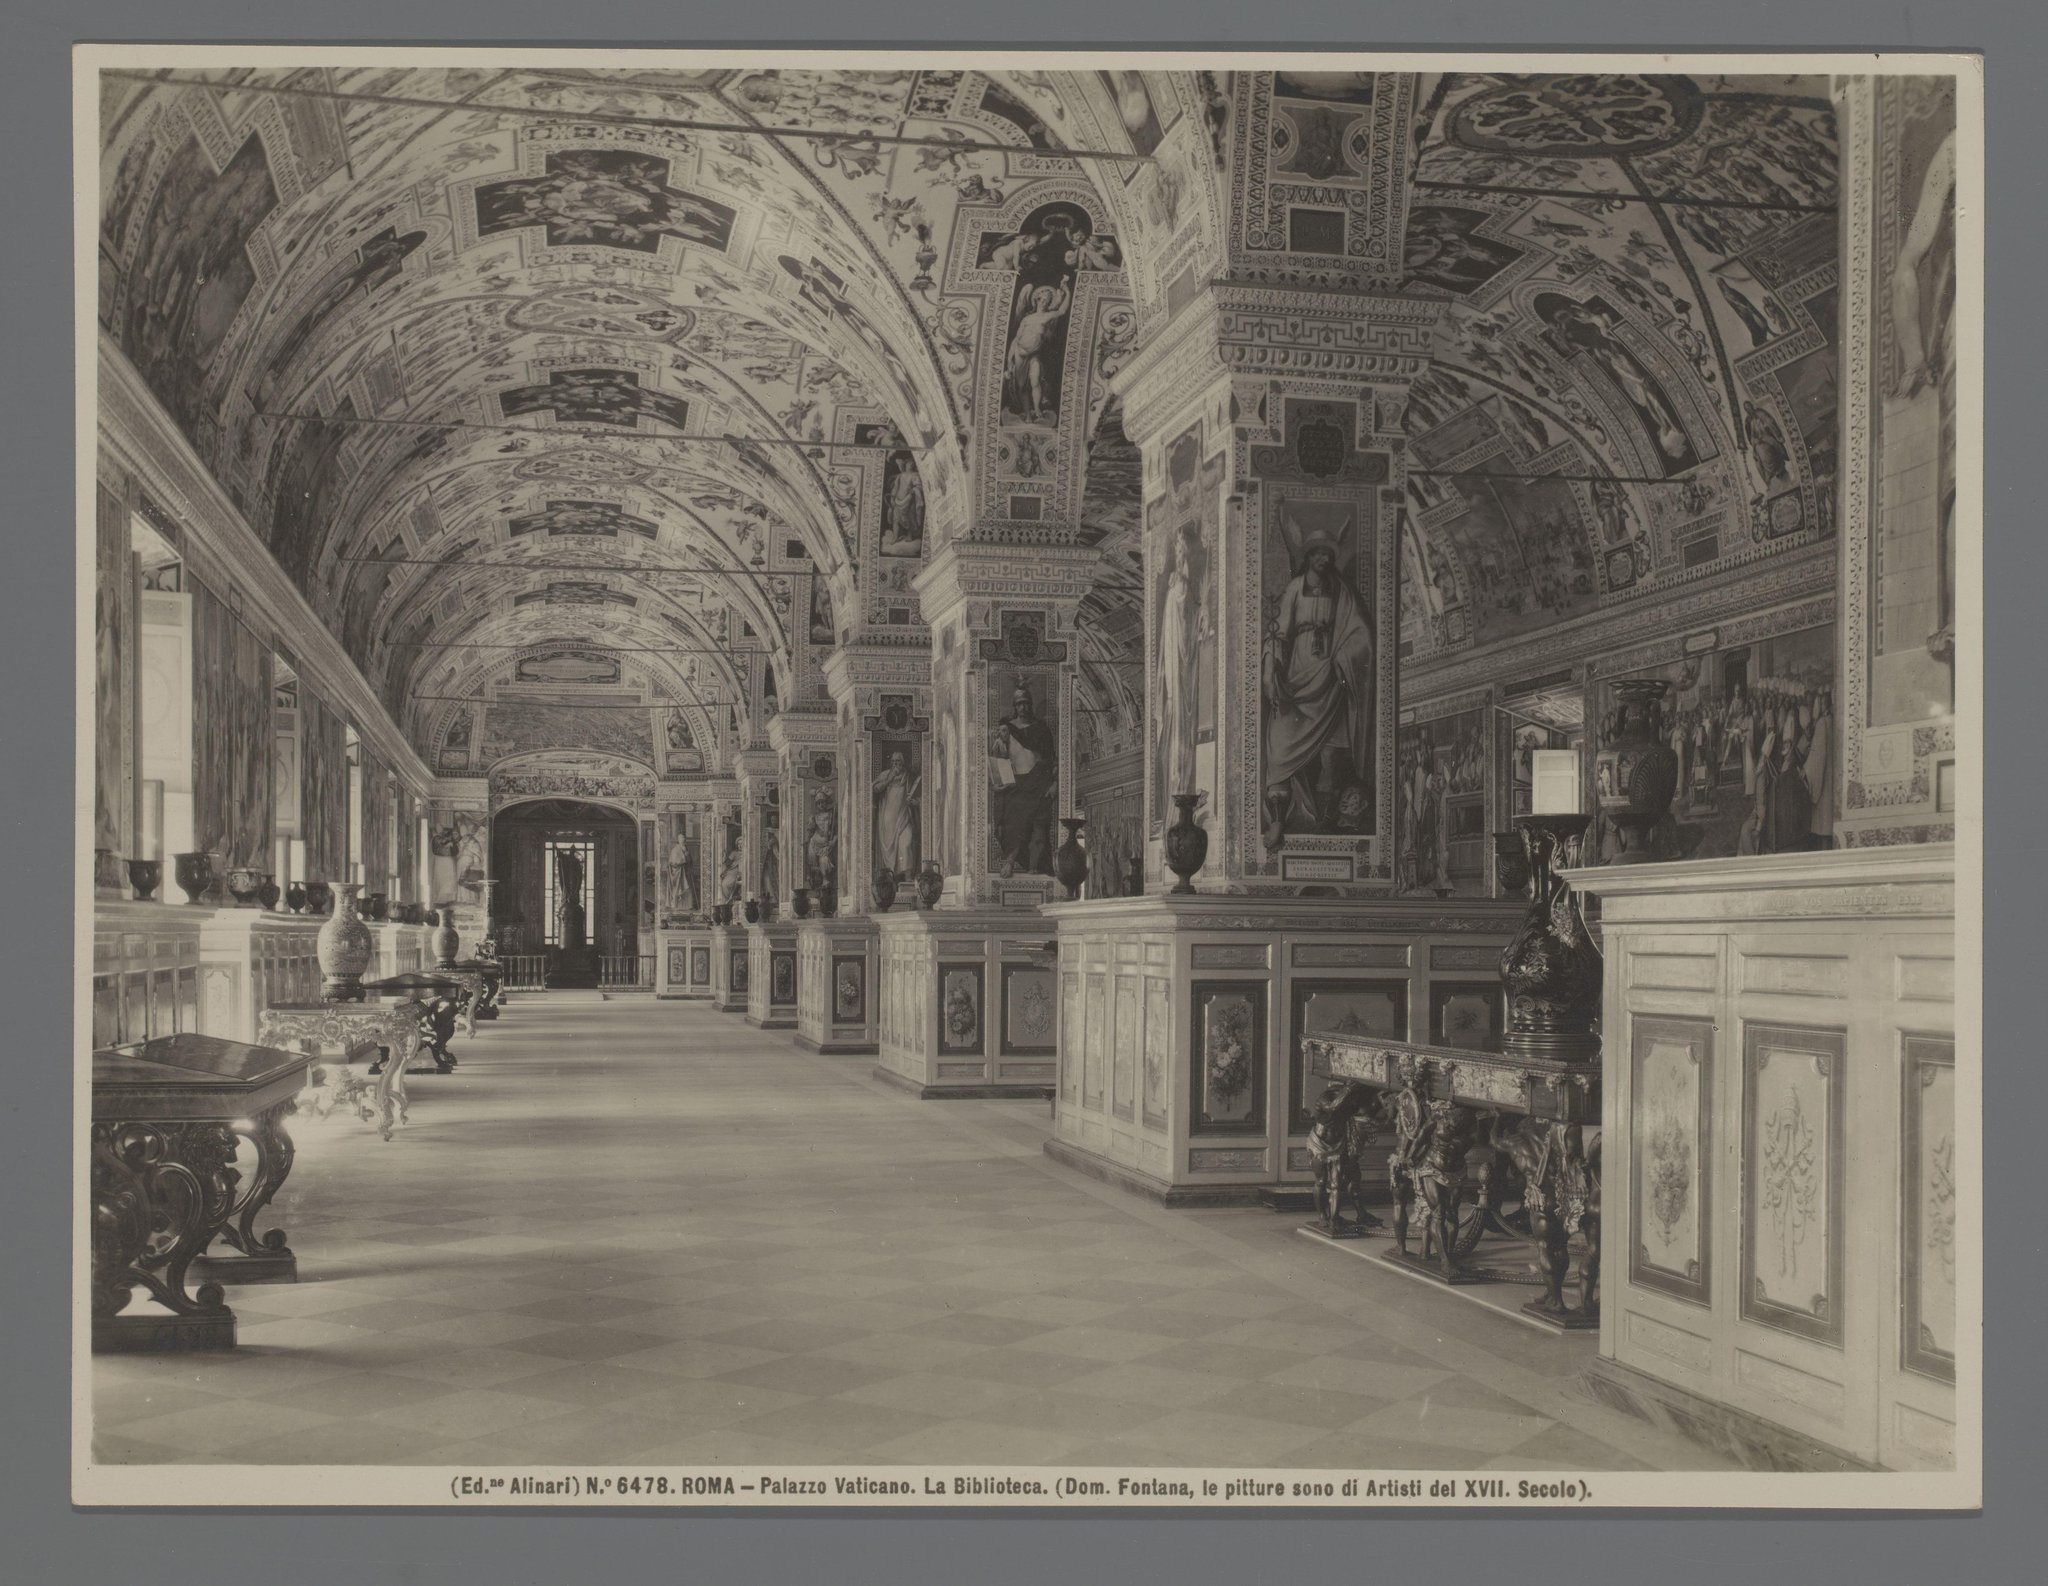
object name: photograph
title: Palazzo Vaticano. La Biblioteca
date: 1880-1920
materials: paper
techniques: gelatin silver print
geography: vatican city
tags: study; 'studiolo'; library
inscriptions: number: ‘No. 6478.’